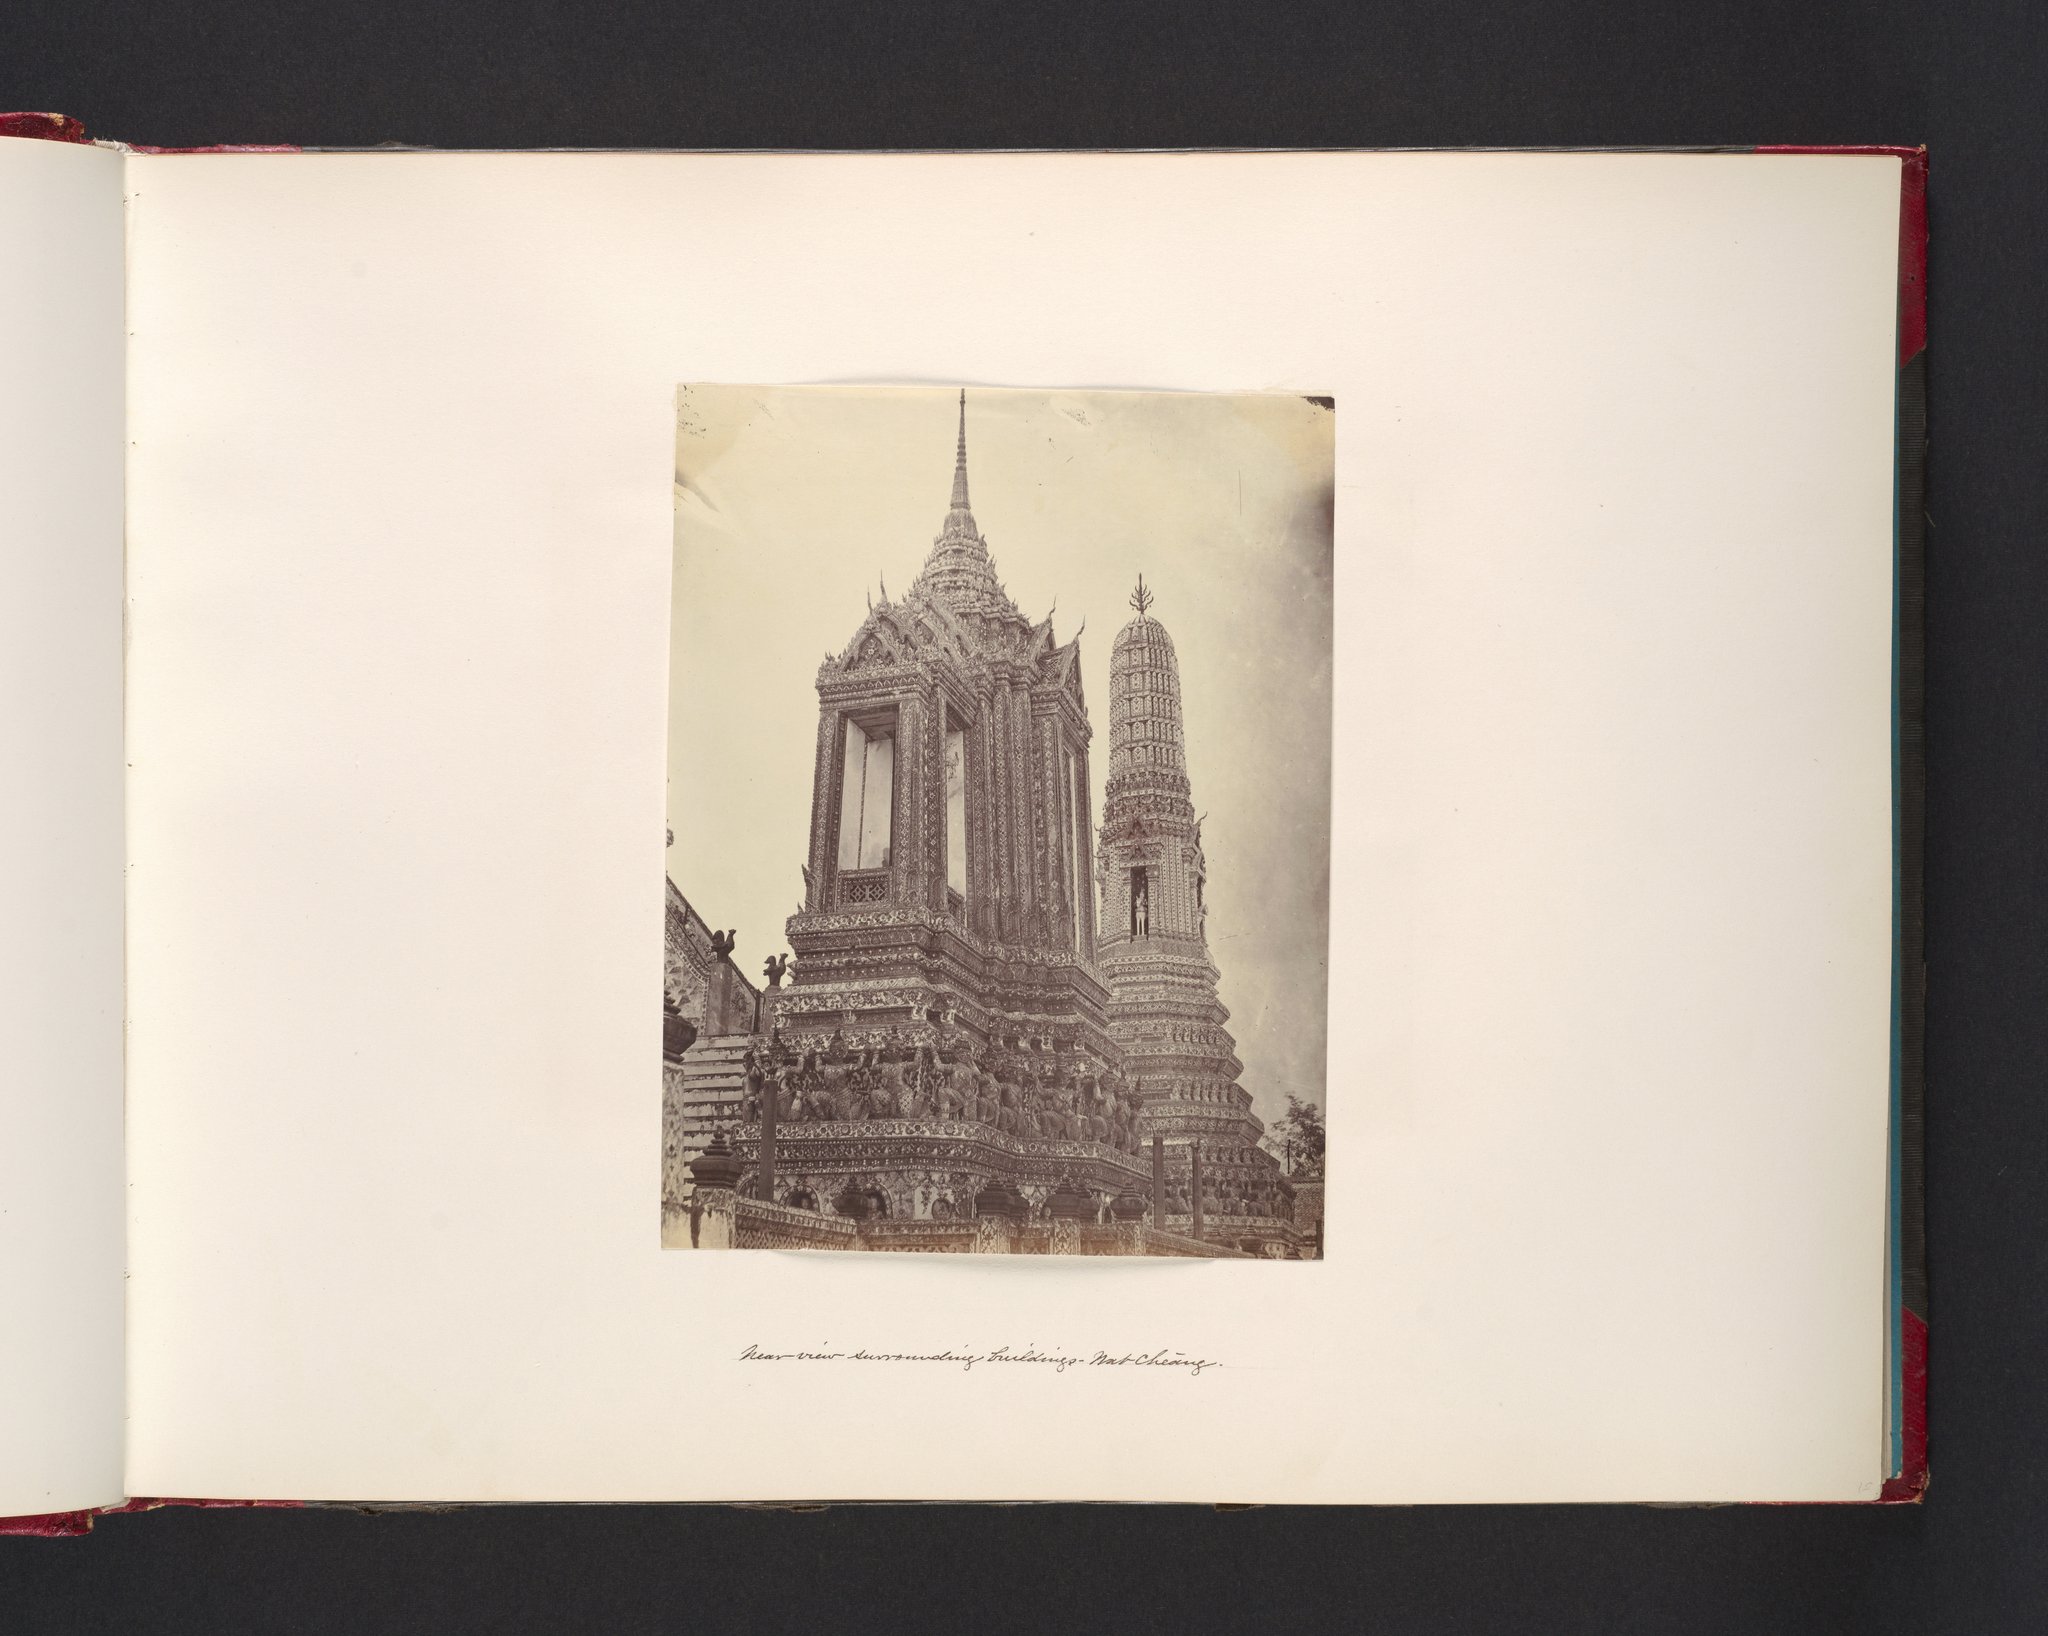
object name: photograph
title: Near View Surrounding Buildings, Wat Chiang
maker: john thomson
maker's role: artist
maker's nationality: british, scottish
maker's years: 1837-1921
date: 1865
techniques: albumen silver print, glass negative